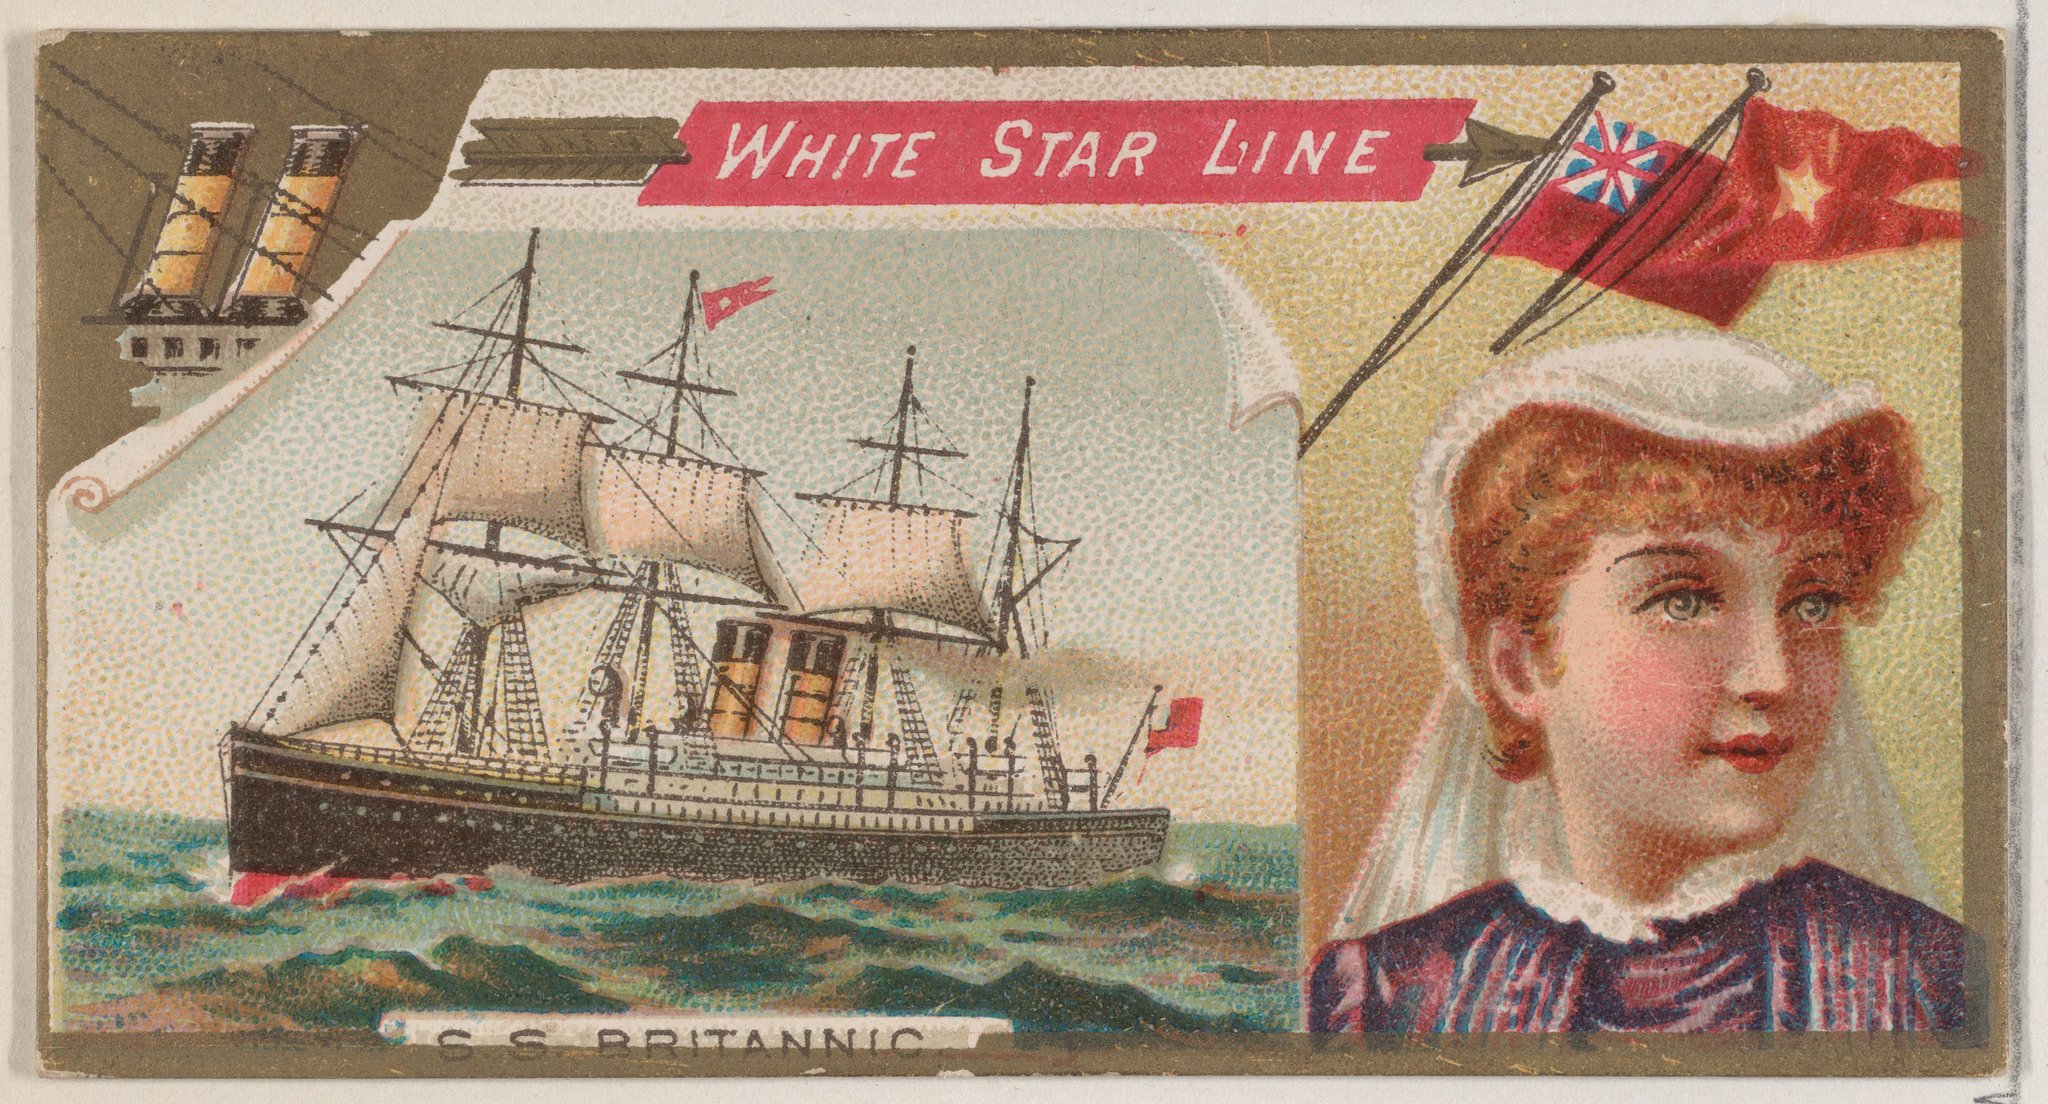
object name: print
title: Steamship Britannic, White Star Line, from the Ocean and River Steamers series (N83) for Duke brand cigarettes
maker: w. duke, sons & co.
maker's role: publisher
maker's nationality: american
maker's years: 1870-1920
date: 1887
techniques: color lithograph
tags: women,ships